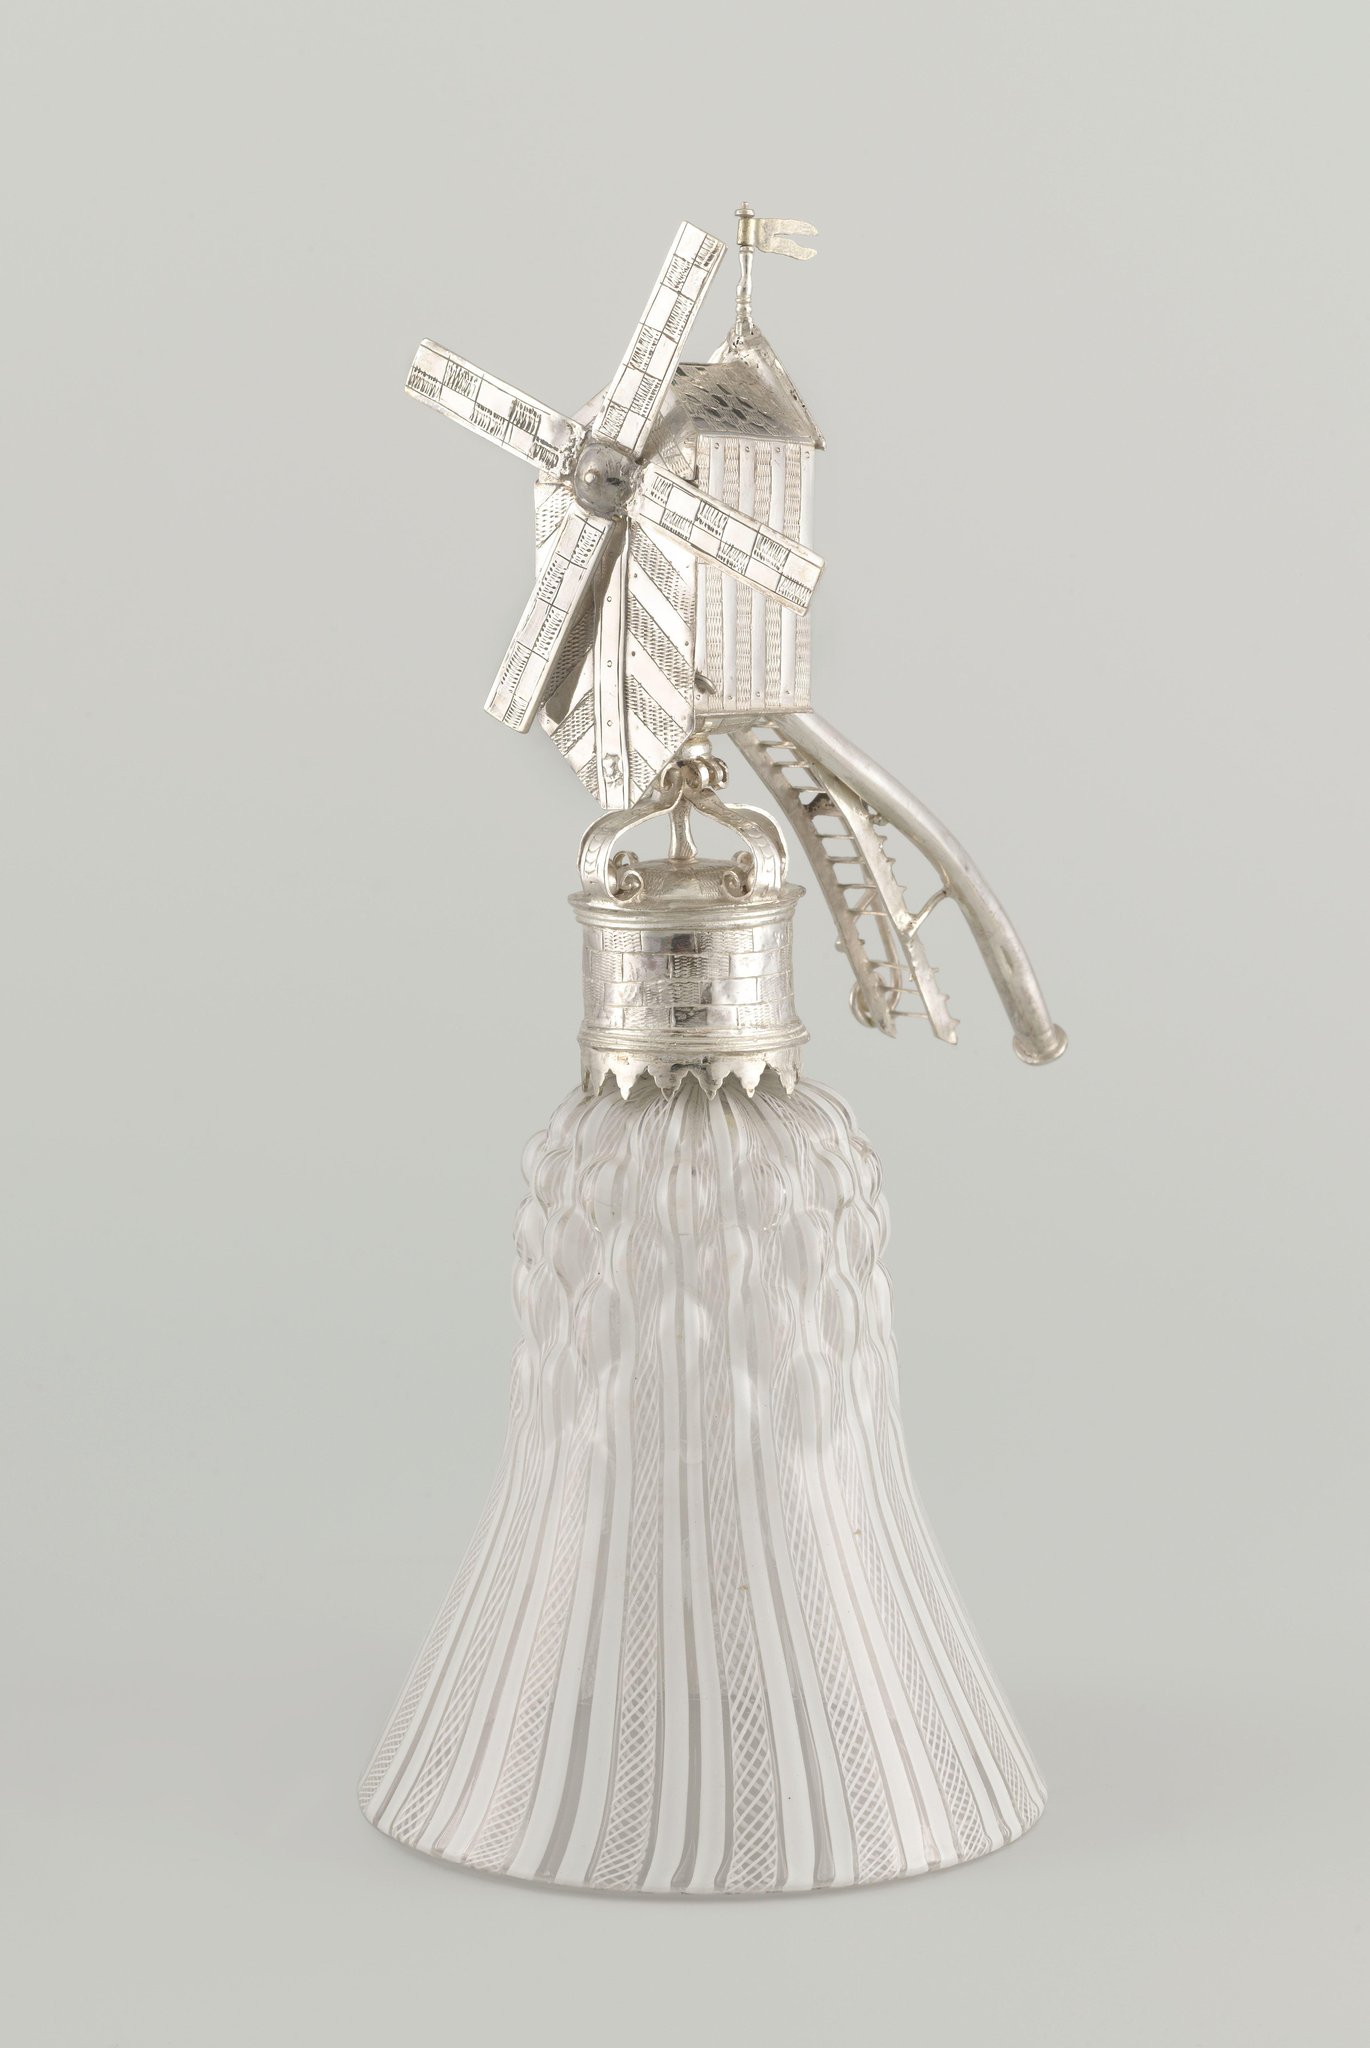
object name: setting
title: Molenbeker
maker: Anonymous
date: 1600-1700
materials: glass, silver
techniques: engraving, façon de venise, glassblowing, vetro a retorti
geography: low countries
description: Molen van zilver, een onleesbaar merk op één der wieken.